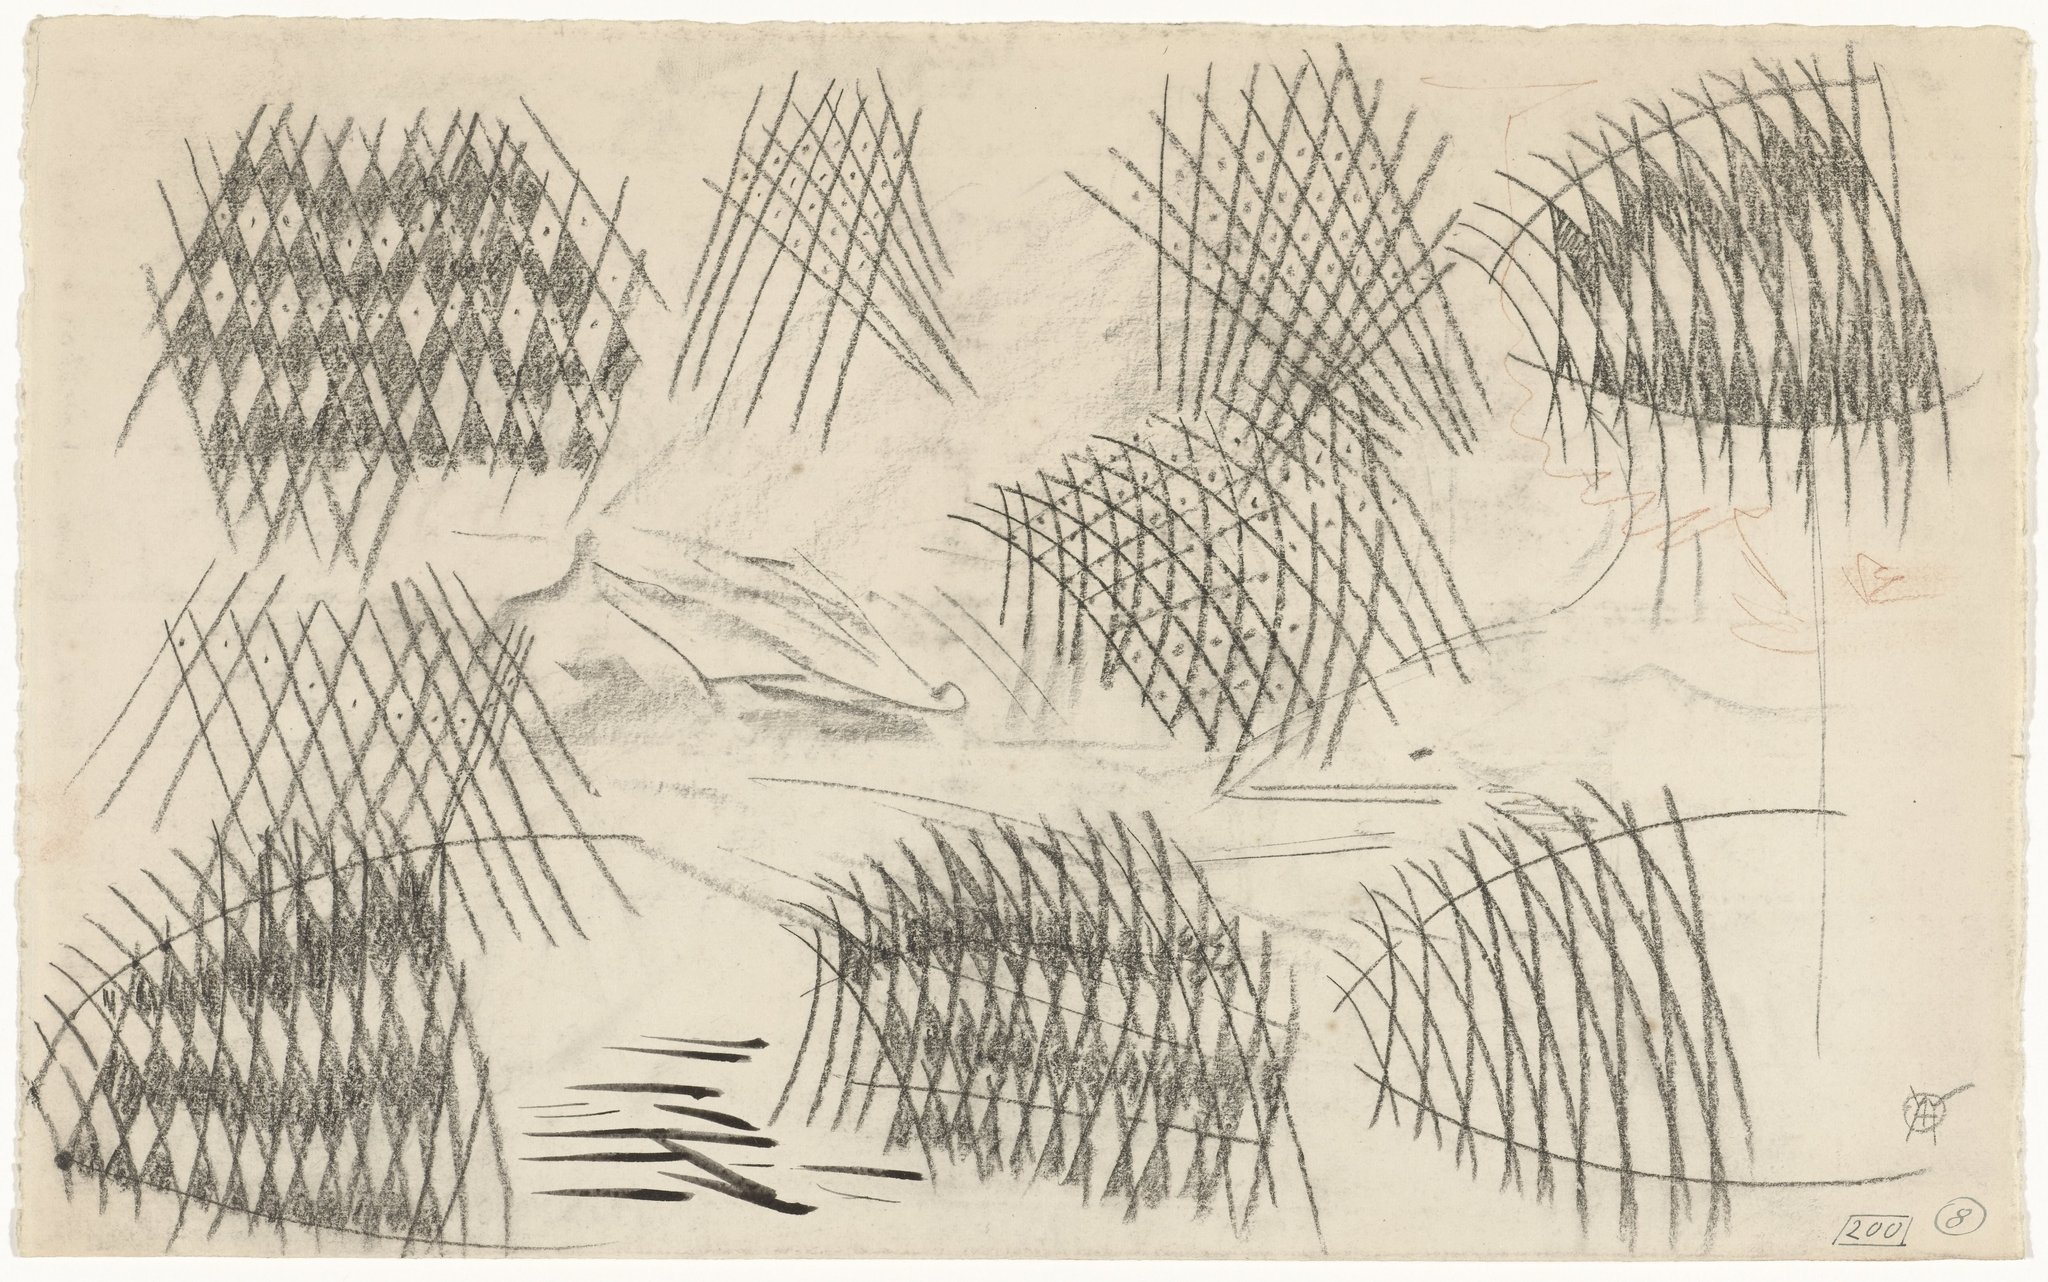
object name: drawing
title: Studies van schubben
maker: gerrit willem dijsselhof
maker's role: designer, draughtsman, print maker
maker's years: 1866-1924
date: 1876-1924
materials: chalk, paper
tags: bony fishes (+ skin, fleece, hide, fur, leather)